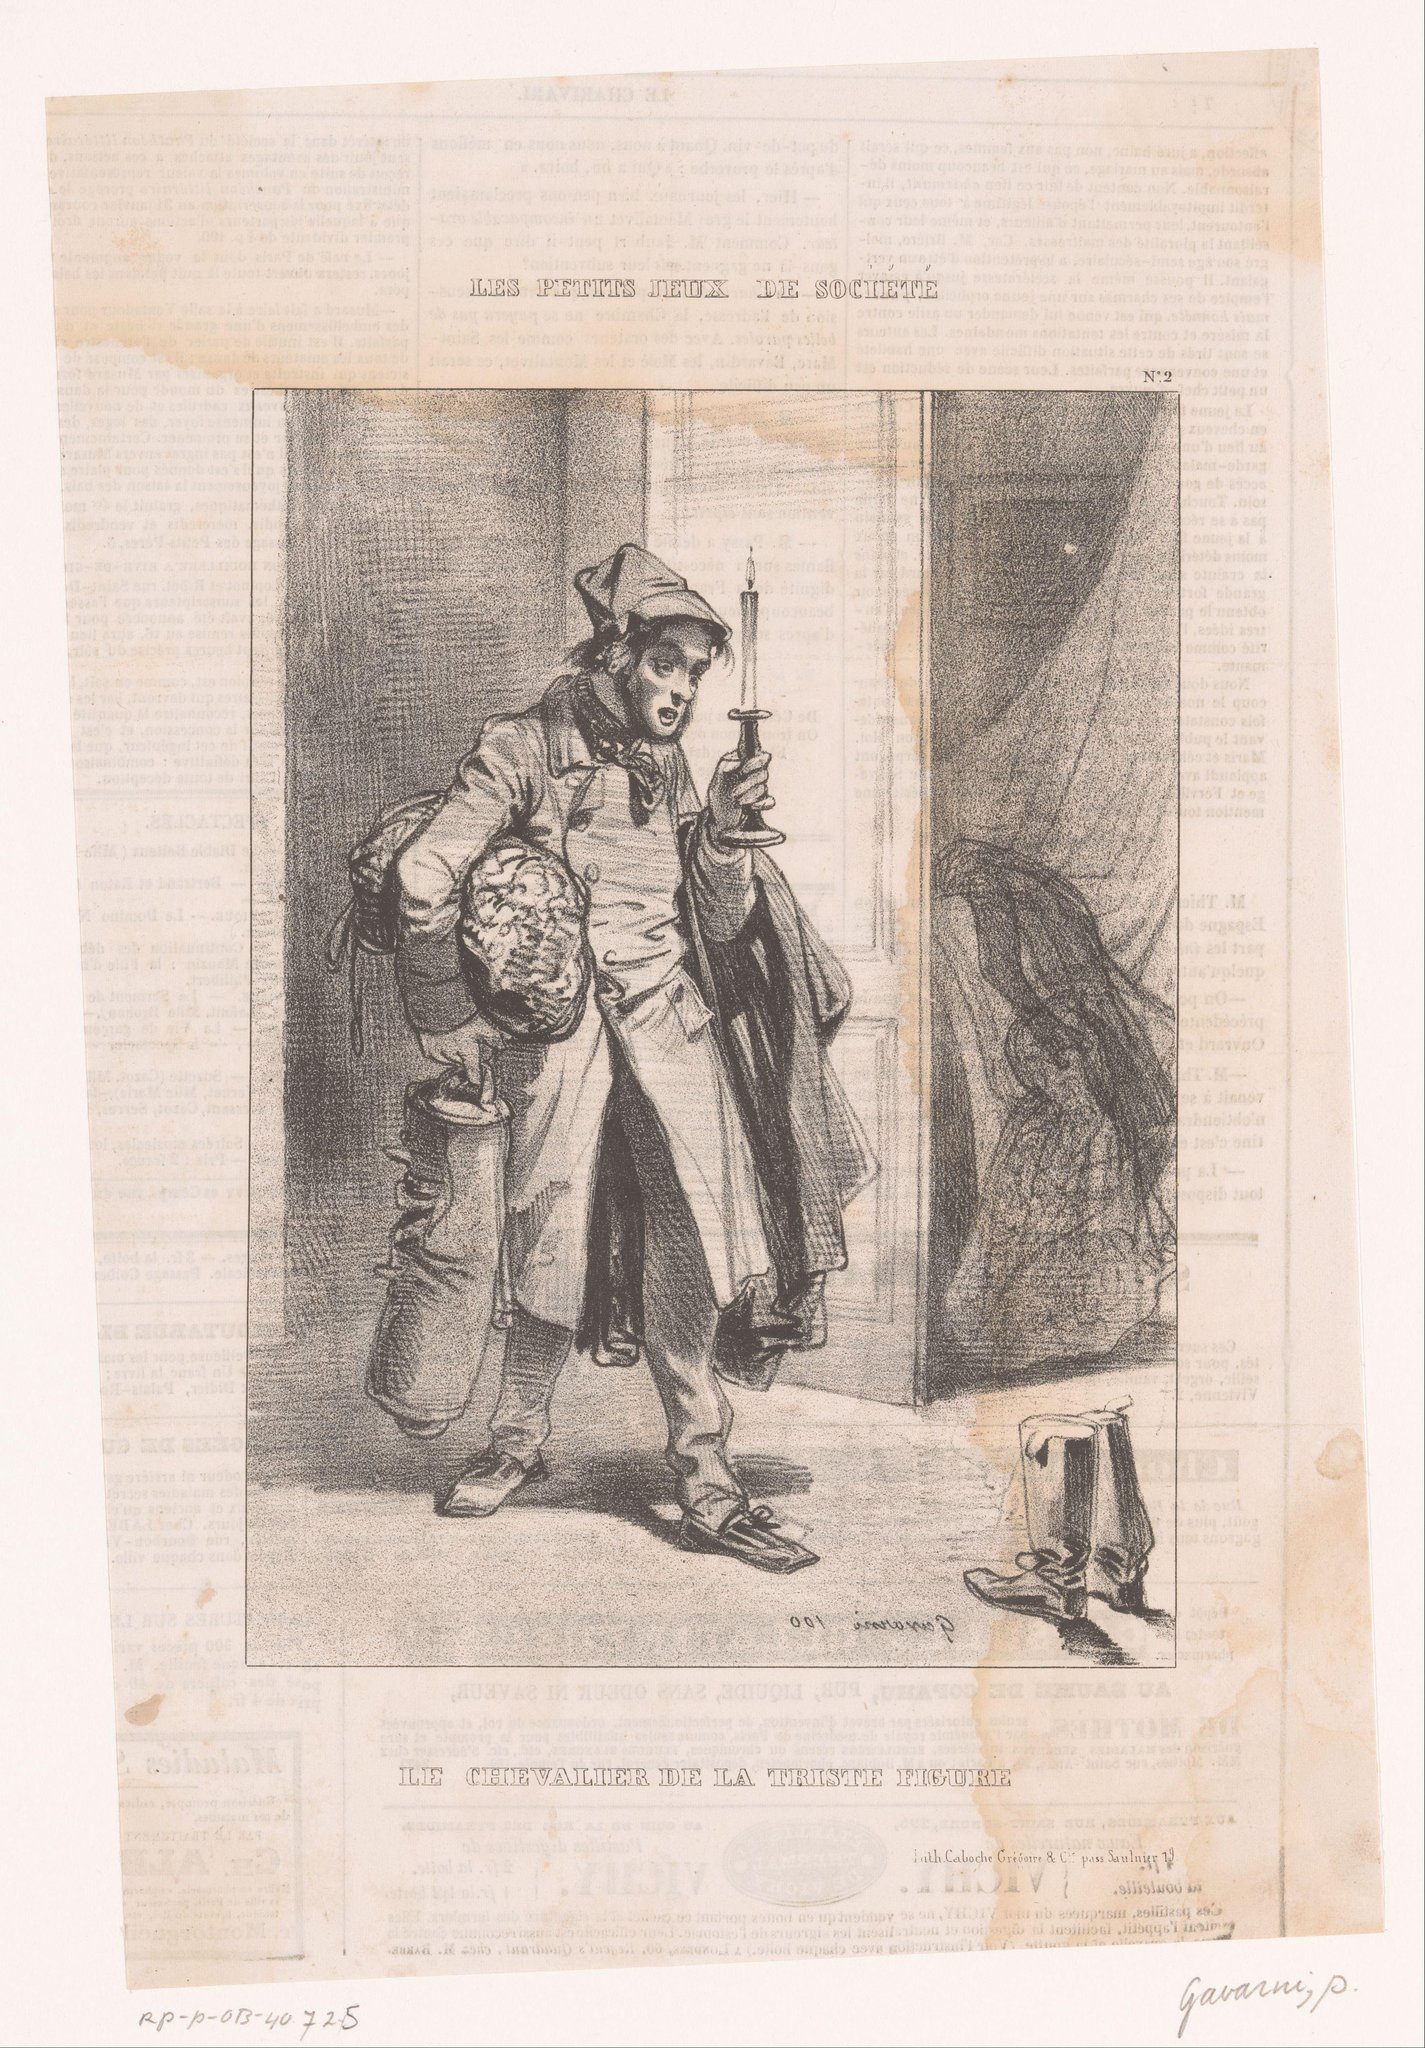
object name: print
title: Hoog spel spelen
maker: paul gavarni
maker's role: draughtsman, print maker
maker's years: 1804-1866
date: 1838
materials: paper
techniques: lithograph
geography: paris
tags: partner deceived, arrival and return ~ travelling, adultery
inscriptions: collector's mark: Lugt 2228a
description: De man, die thuiskomt na een reis, wordt verrast door een paar laarzen in de kamer. Op de achtergrond hangt een jas van een man samen met een jurk over een fauteuil.